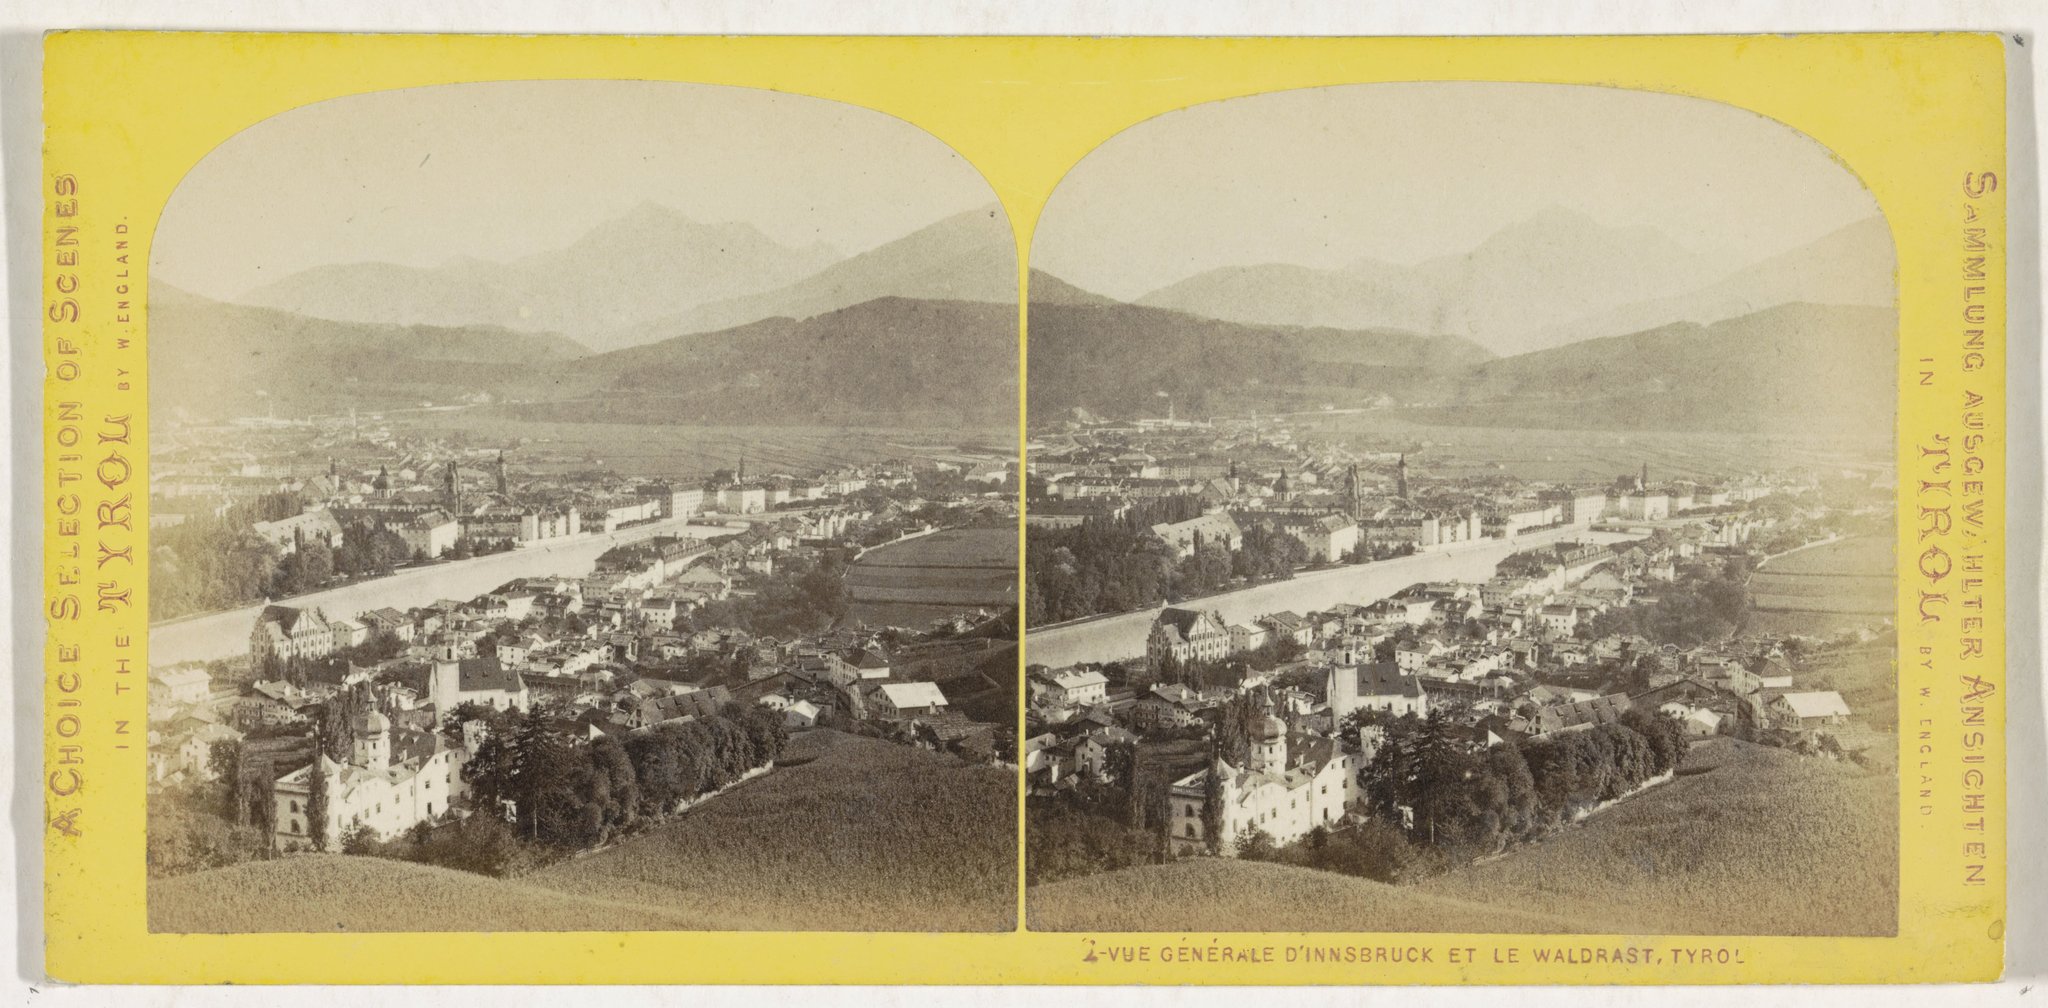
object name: stereograph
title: Gezicht op Innsbruck en Waldrast op de achtergrond, Oostenrijk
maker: william england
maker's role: fotograaf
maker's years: 1816-1896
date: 1863-1865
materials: cardboard, paper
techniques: albumen print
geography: austria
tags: city-view in general; 'veduta', mountains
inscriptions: number: ‘2’